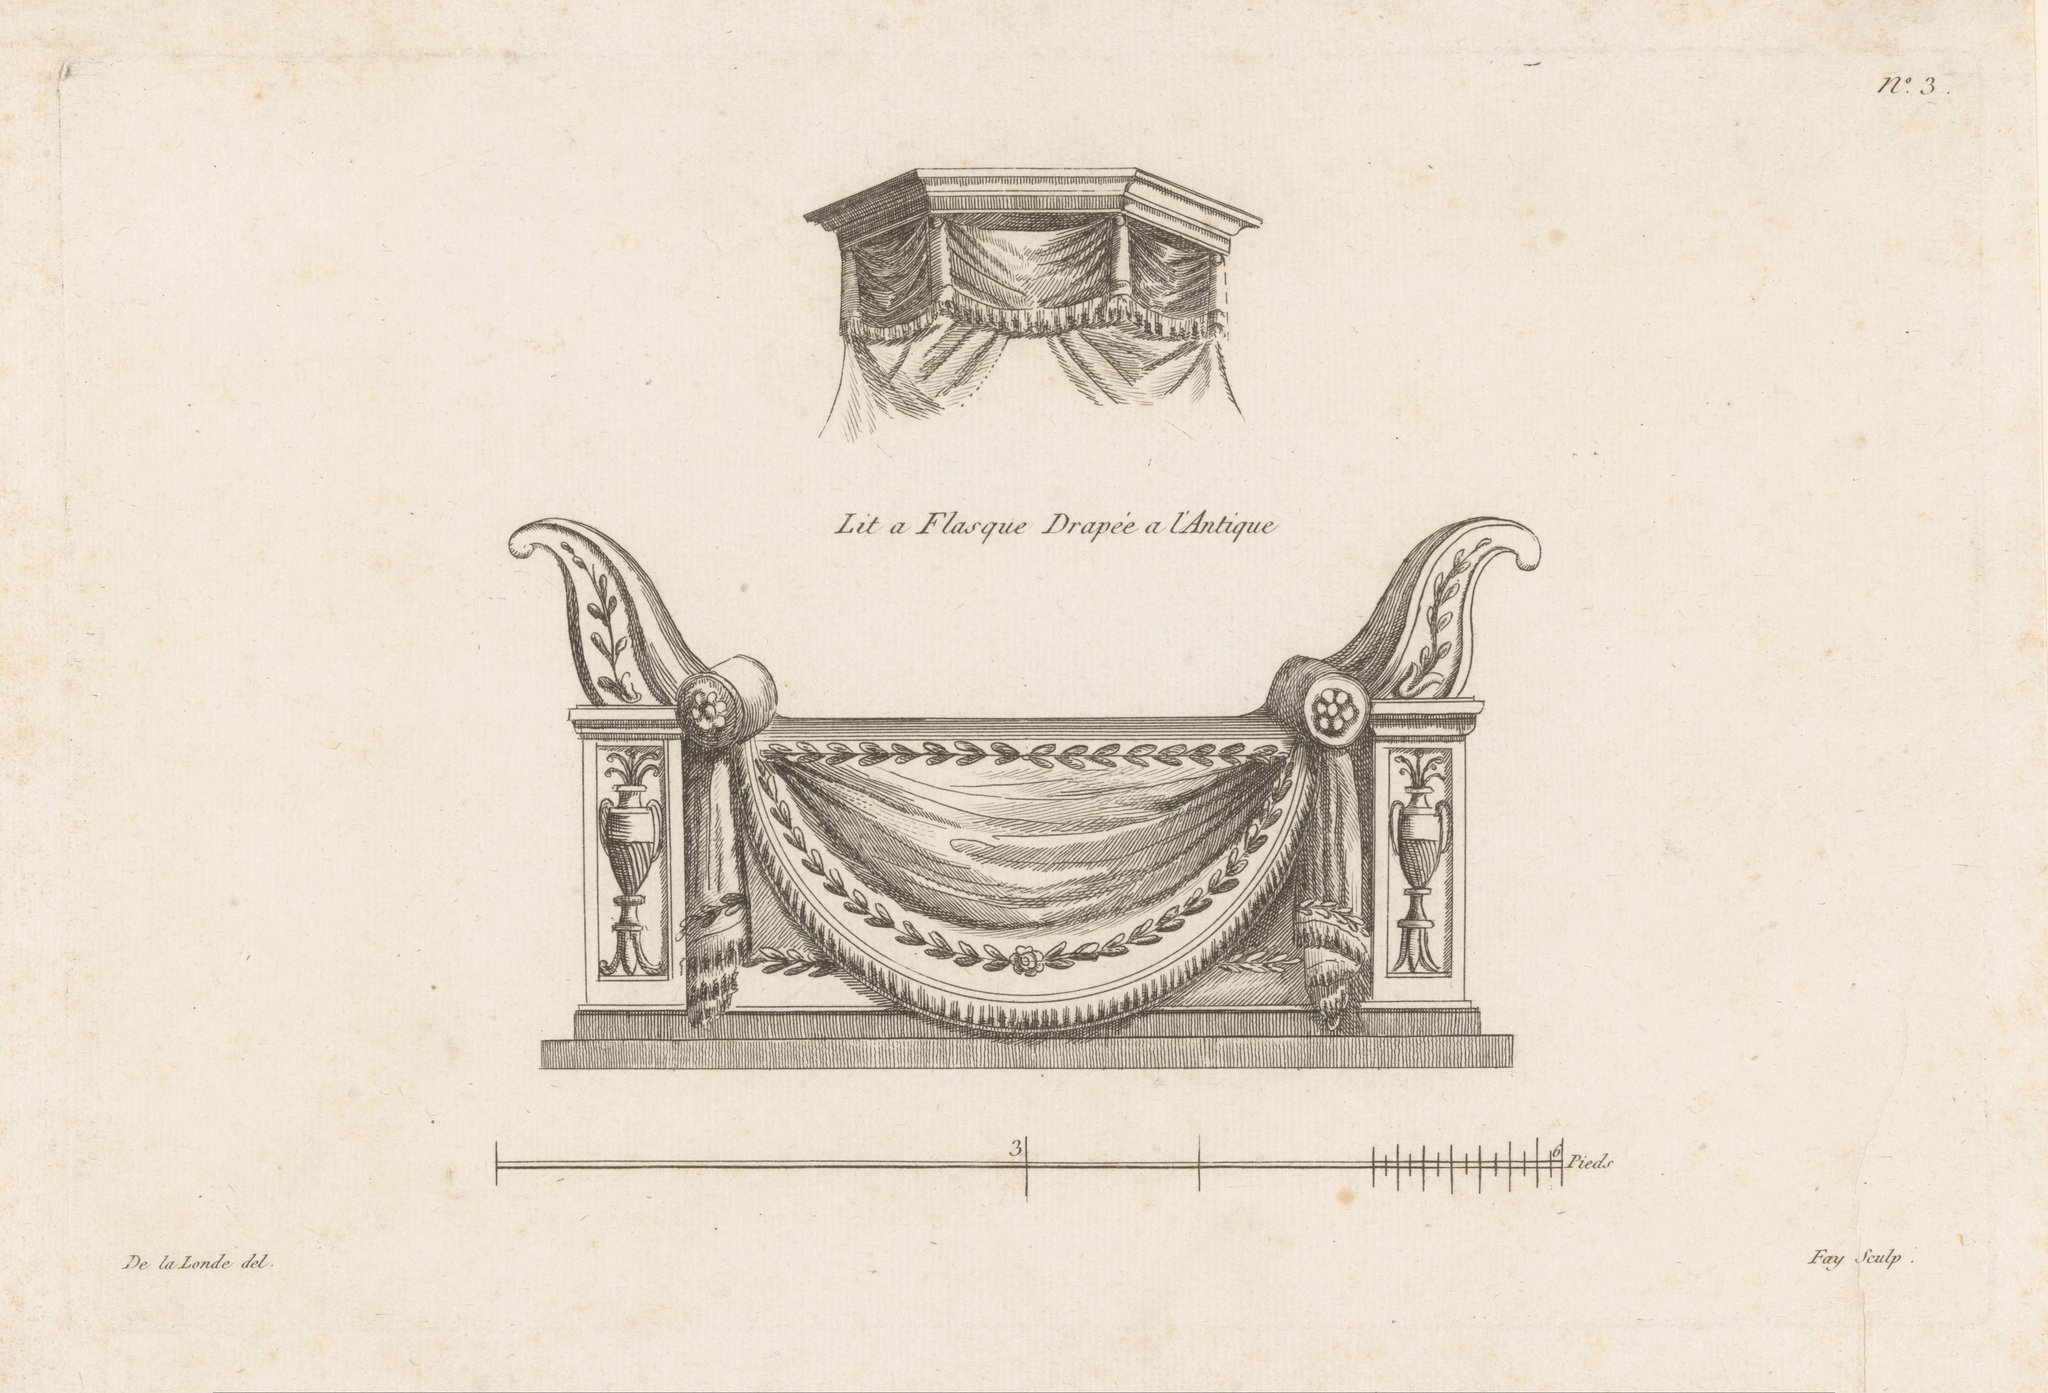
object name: ornament print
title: Aanligbed en bekroning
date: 1784-1796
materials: paper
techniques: etching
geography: paris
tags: bed with tester, bed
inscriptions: collector's mark: Lugt 2760, collector's mark: Lugt 2228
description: Een geornamenteerde aanligbed met twee rolkussens, bladmotieven en vazen. Daarboven een bekroning van een bedhemel.